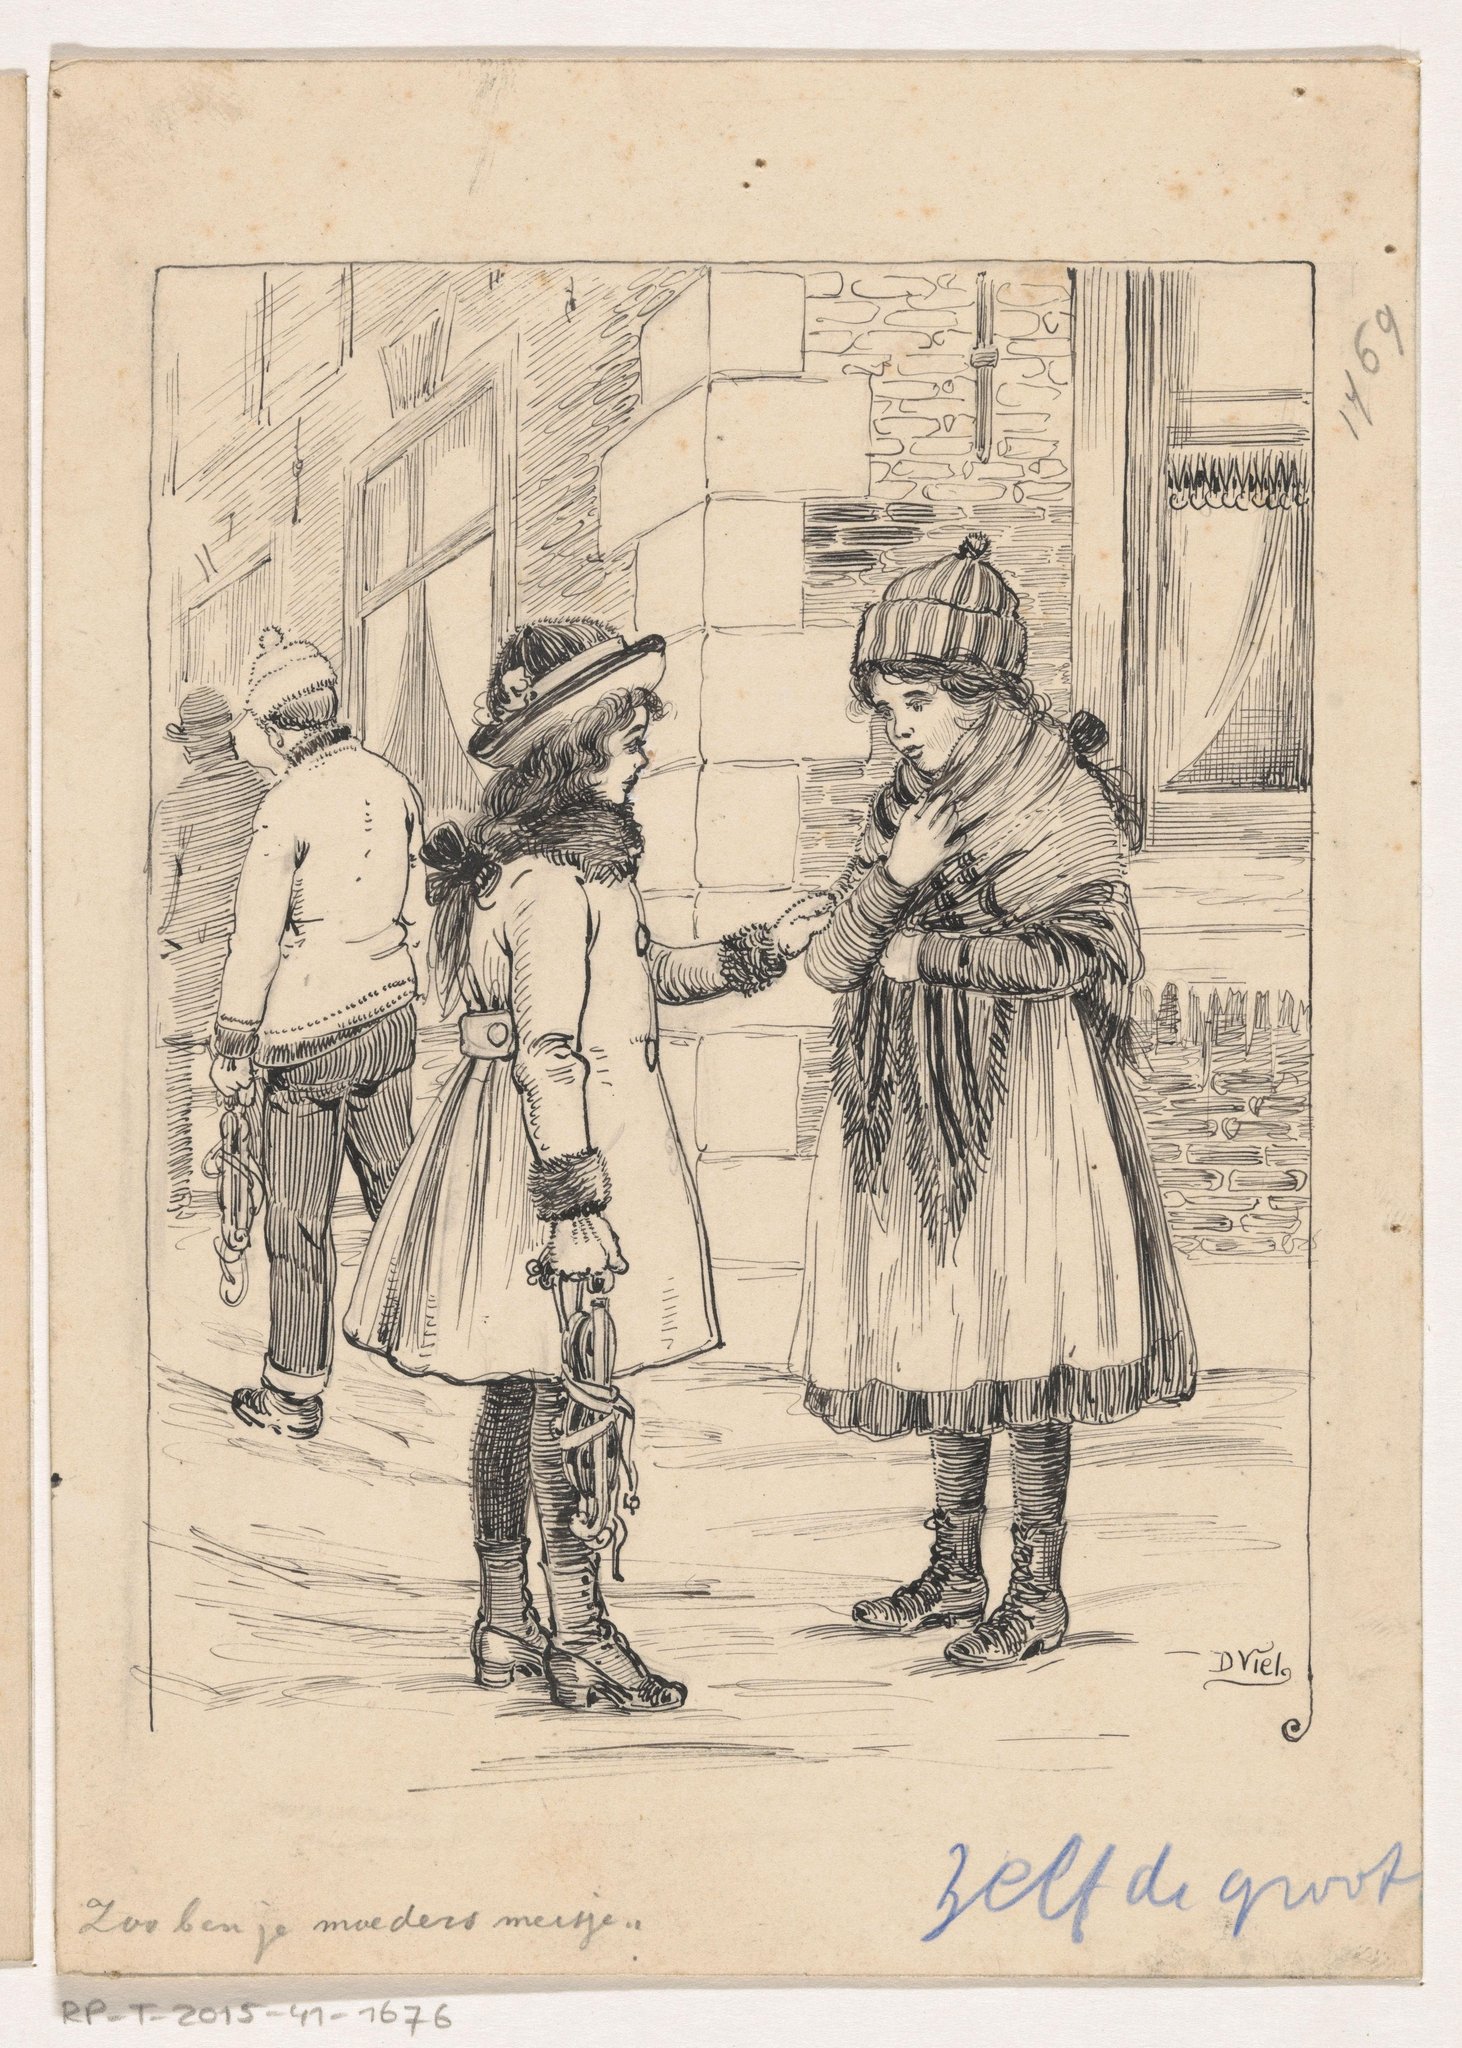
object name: drawing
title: Twee meisjes op een straathoek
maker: d. viel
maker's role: draughtsman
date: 1915-1935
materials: ink, paper, pencil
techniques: pen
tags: girl (child between toddler and youth), street (+ city(-scape) with figures, staffage)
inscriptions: :, signature: ‘D Viel.’, collector's mark: Lugt 2228, annotation: ‘Zoo ben je moeders meisje ..’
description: Twee meisjes staan op een straathoek. Het is winters weer. Het linker meisje draagt een met bont afgezette jas en houdt de arm vast van de ander, die een sjaal om haar schouders heeft geslagen.